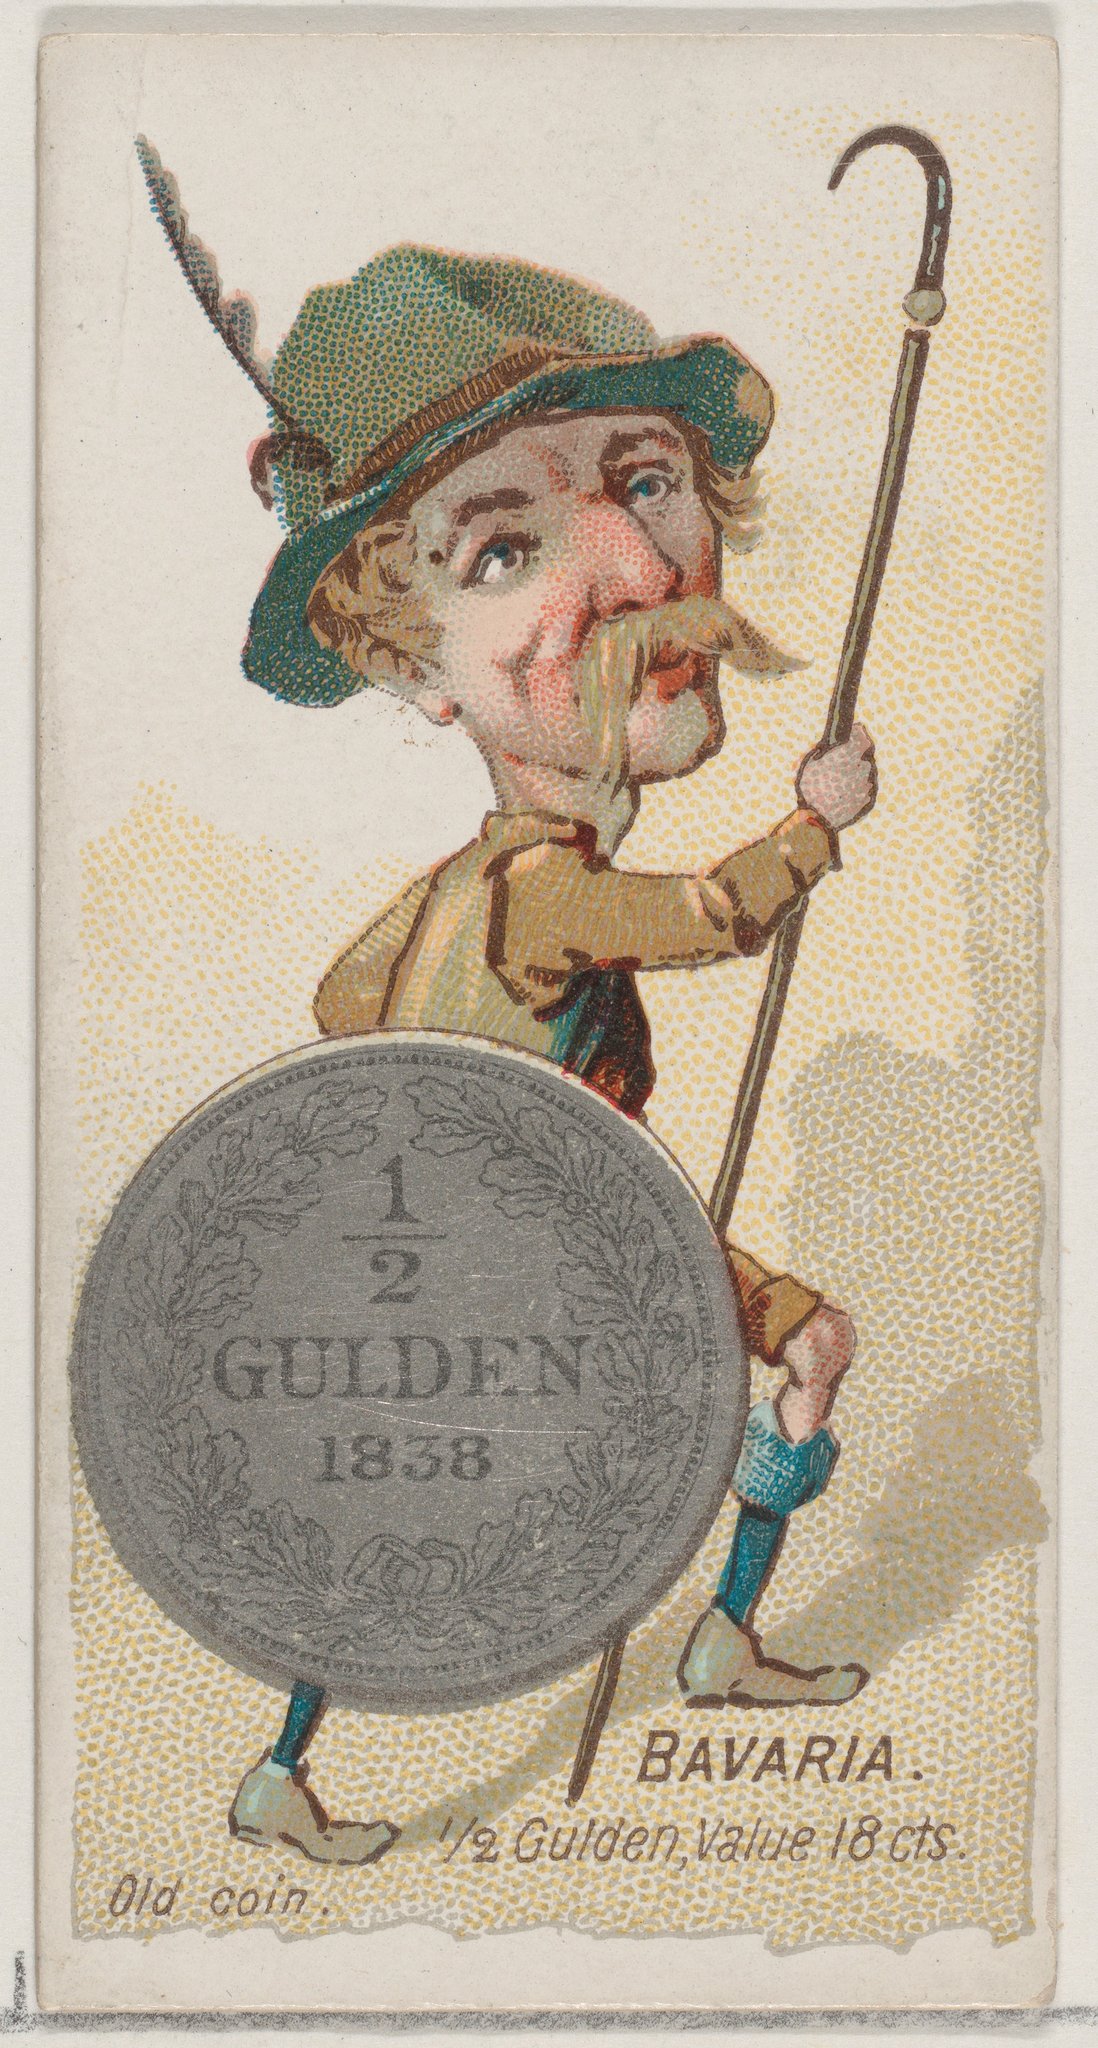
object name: print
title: Bavaria, 1/2 Gulden, from the series Coins of All Nations (N72, variation 1) for Duke brand cigarettes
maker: w. duke, sons & co.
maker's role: publisher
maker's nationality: american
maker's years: 1870-1920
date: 1889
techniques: color lithograph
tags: men,coins